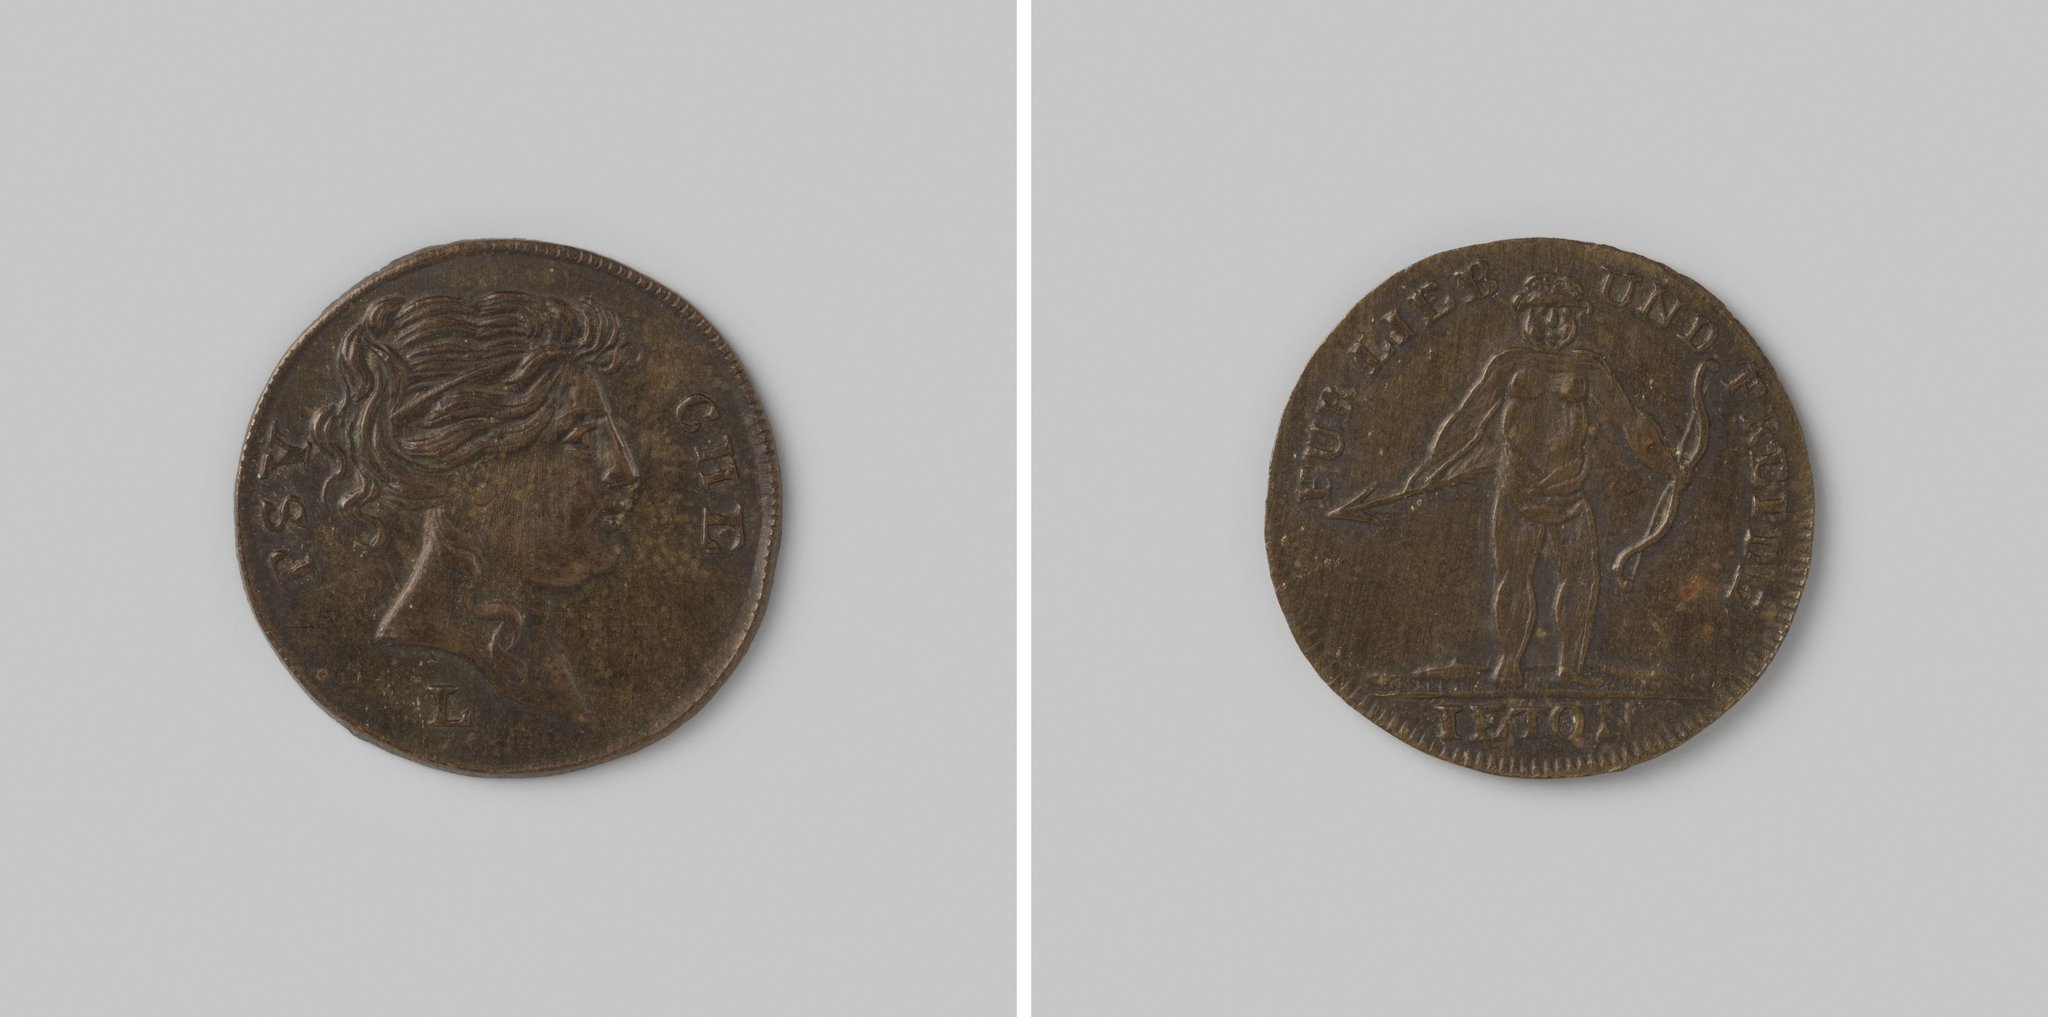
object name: jeton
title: Speelpenning uit Neurenberg met Psyche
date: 1790-1810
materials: brass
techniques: striking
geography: nuremberg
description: Mwessing penning, op de voorzijde het portret van Psyche naar rechts met omschrift, op de keerzijde Cupido staande en face met omschrift en afsnedetekst.